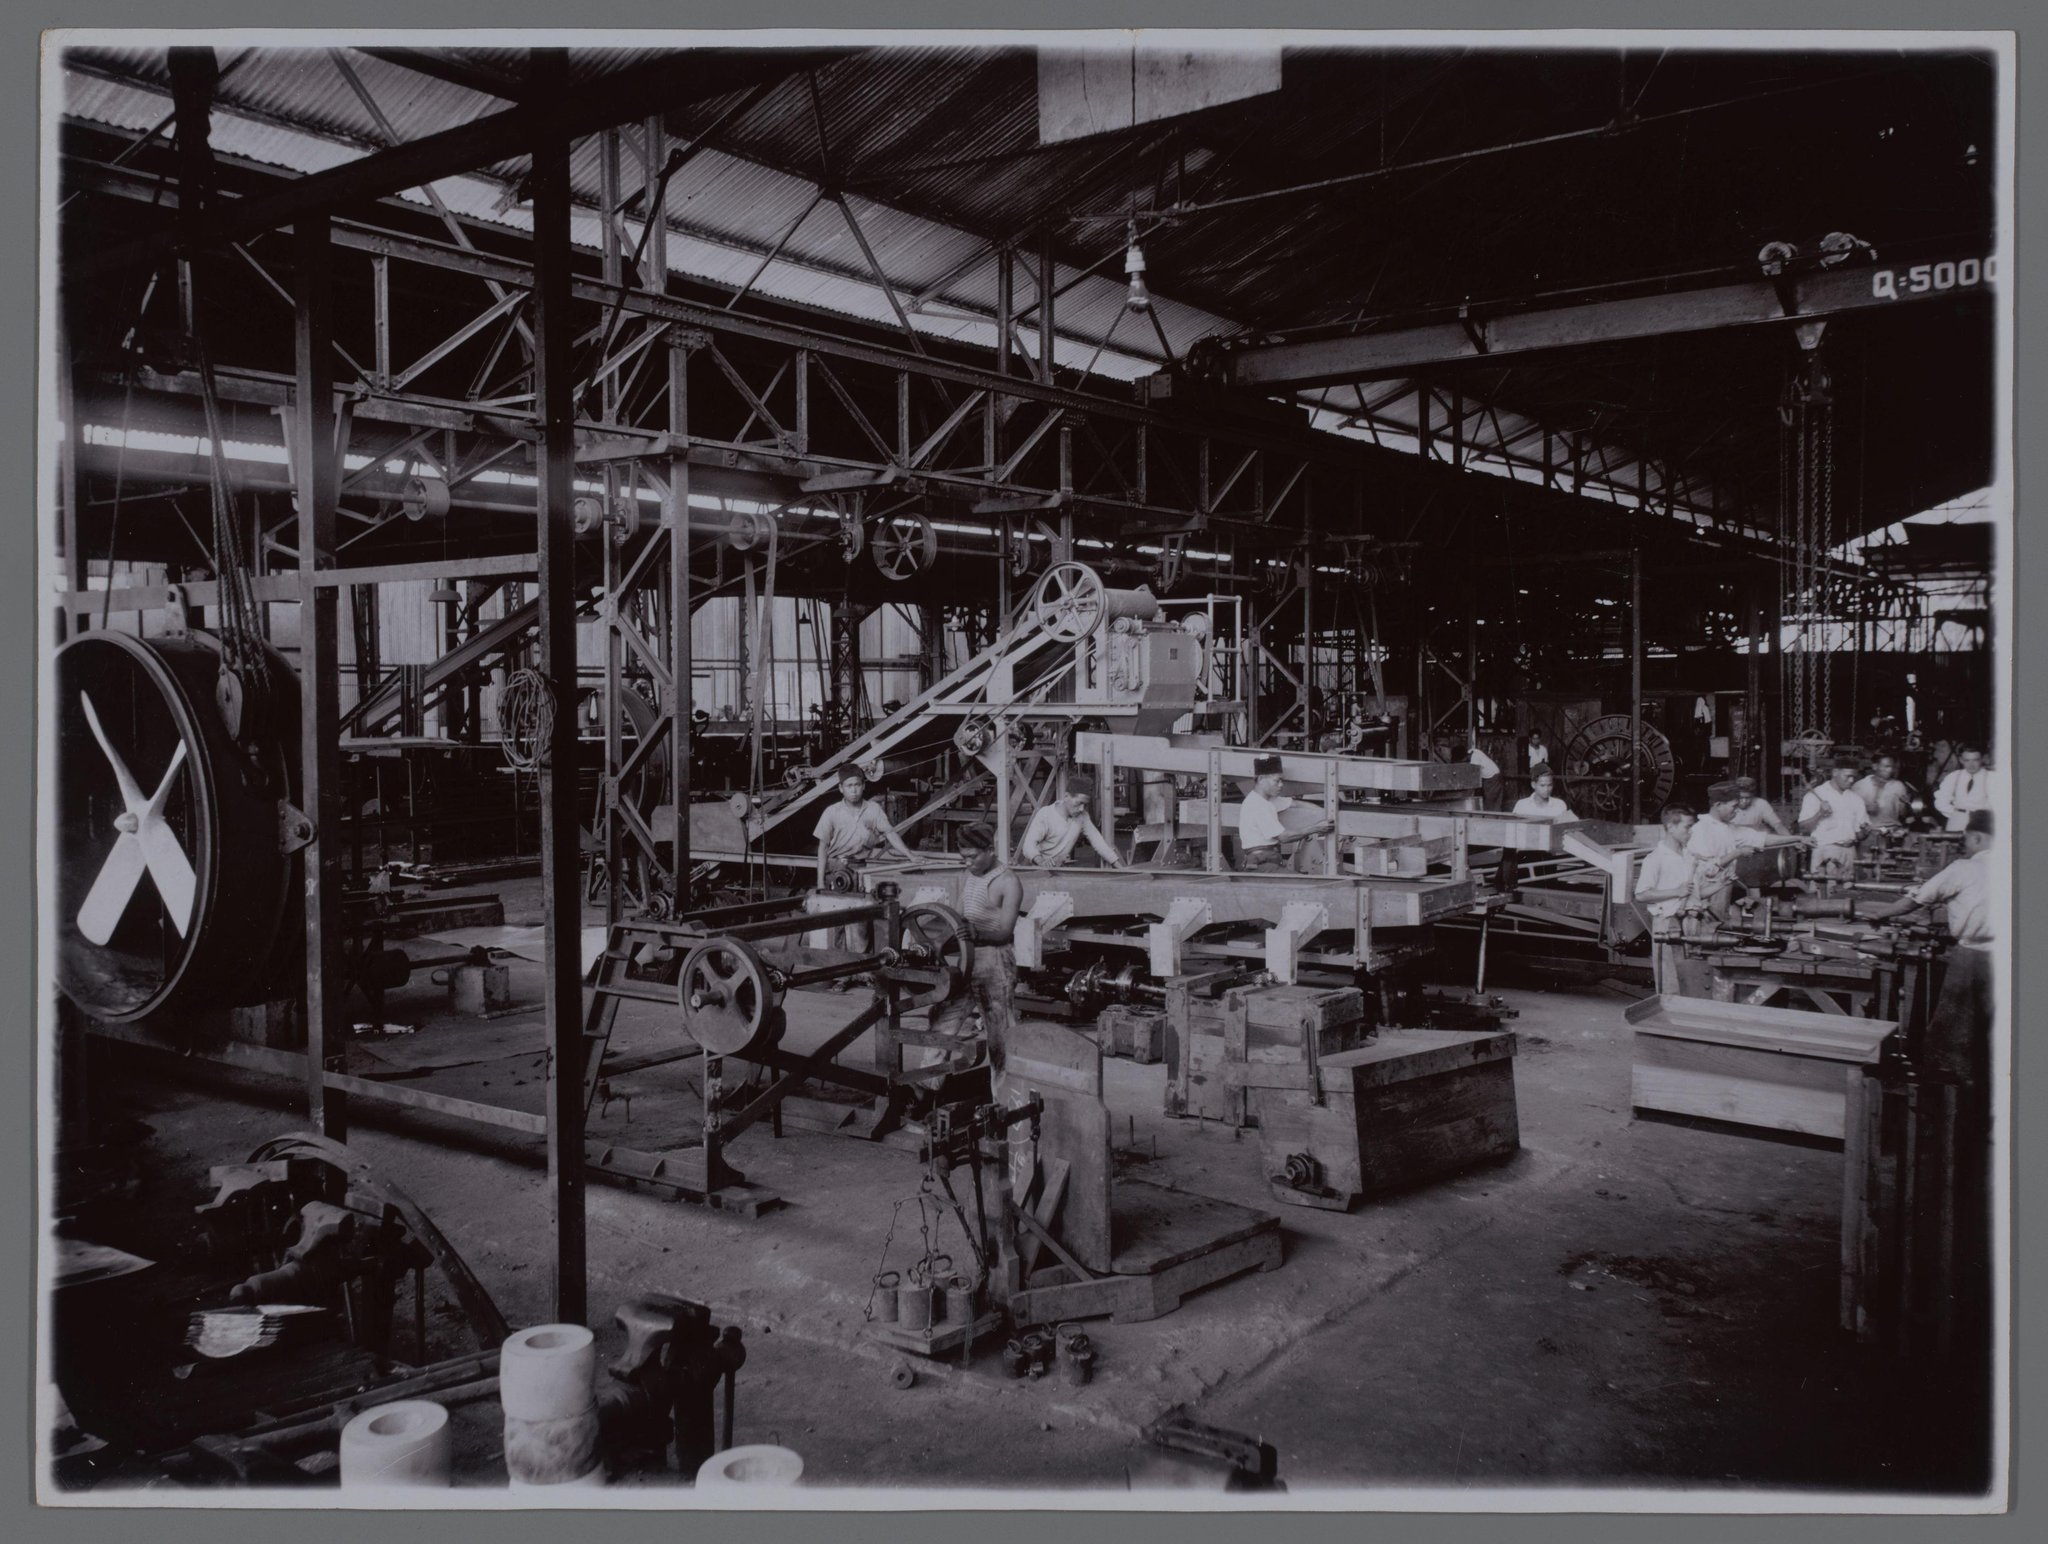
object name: photograph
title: Bankwerkerij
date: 1929-1932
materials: photographic support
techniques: photography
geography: sukabumi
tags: colonial system, machines; parts of machines; tools and appliances, factory-interior, machine shop (+ men (labourers)), java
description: Fabriekshal met de bankwerkerij te Soekaboemi, ca. 1931. Onderdeel van de multomap met foto's van machines van de N.V. Machinefabriek Braat te Soerabaja, Soekaboemi en Jogyakarta, uit de periode 1908-1942.